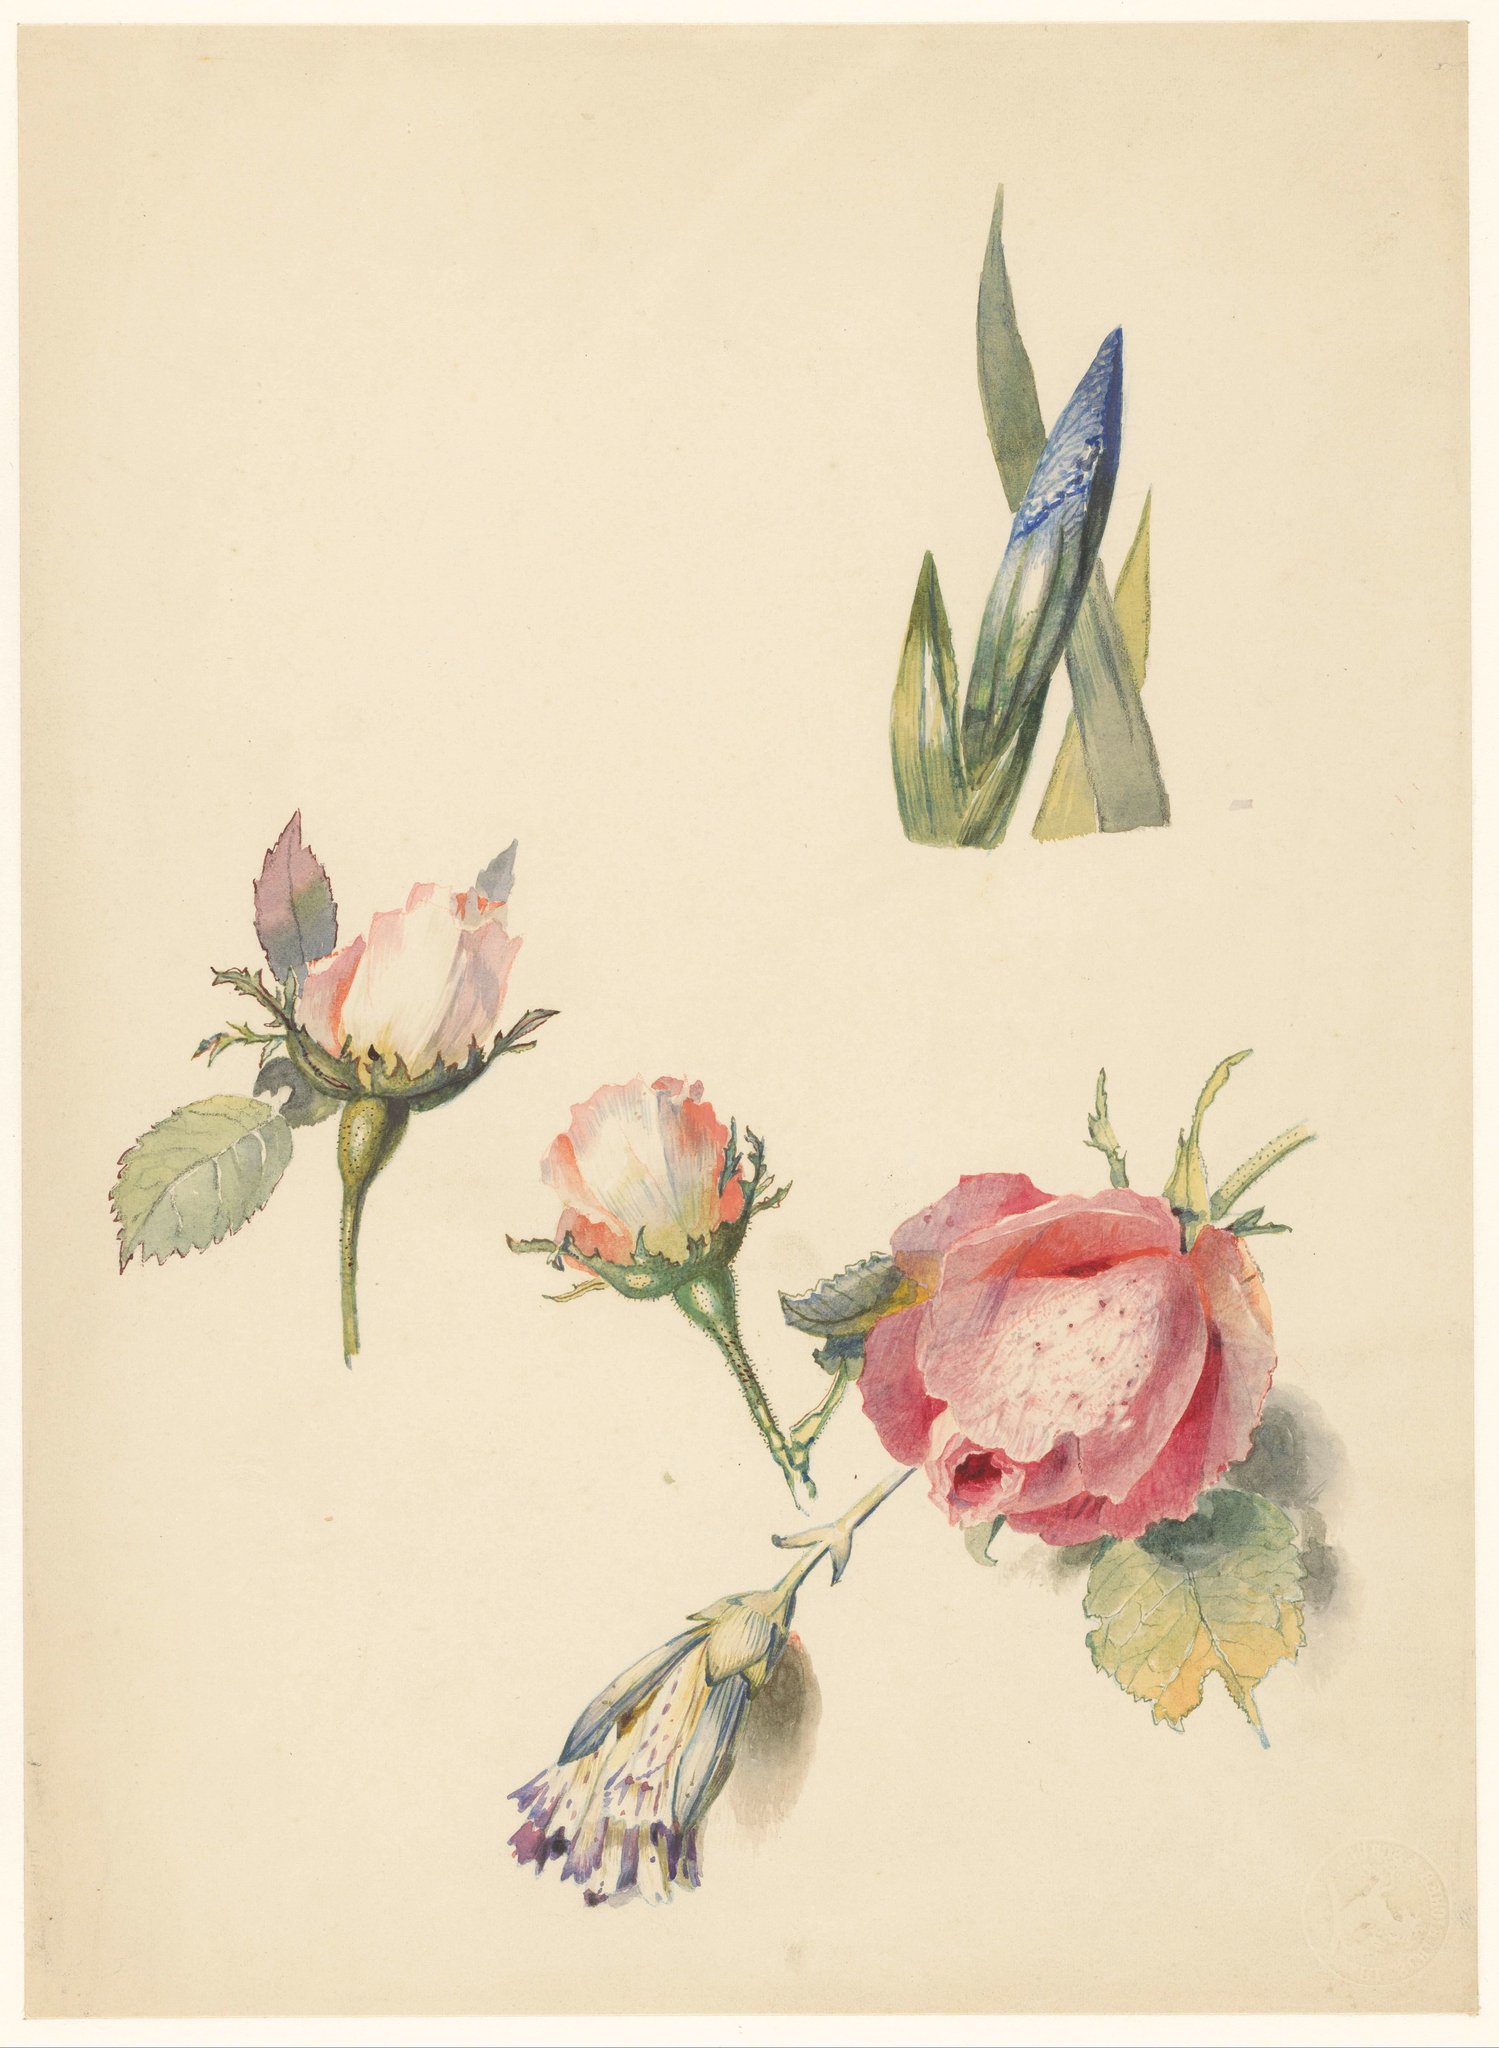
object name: watercolor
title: Studieblad met drie rozen en een iris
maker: albertus steenbergen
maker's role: draughtsman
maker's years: 1814-1900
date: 1824-1900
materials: ink, paper, pencil, watercolor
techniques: brush, pen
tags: flowers: rose, flowers: iris